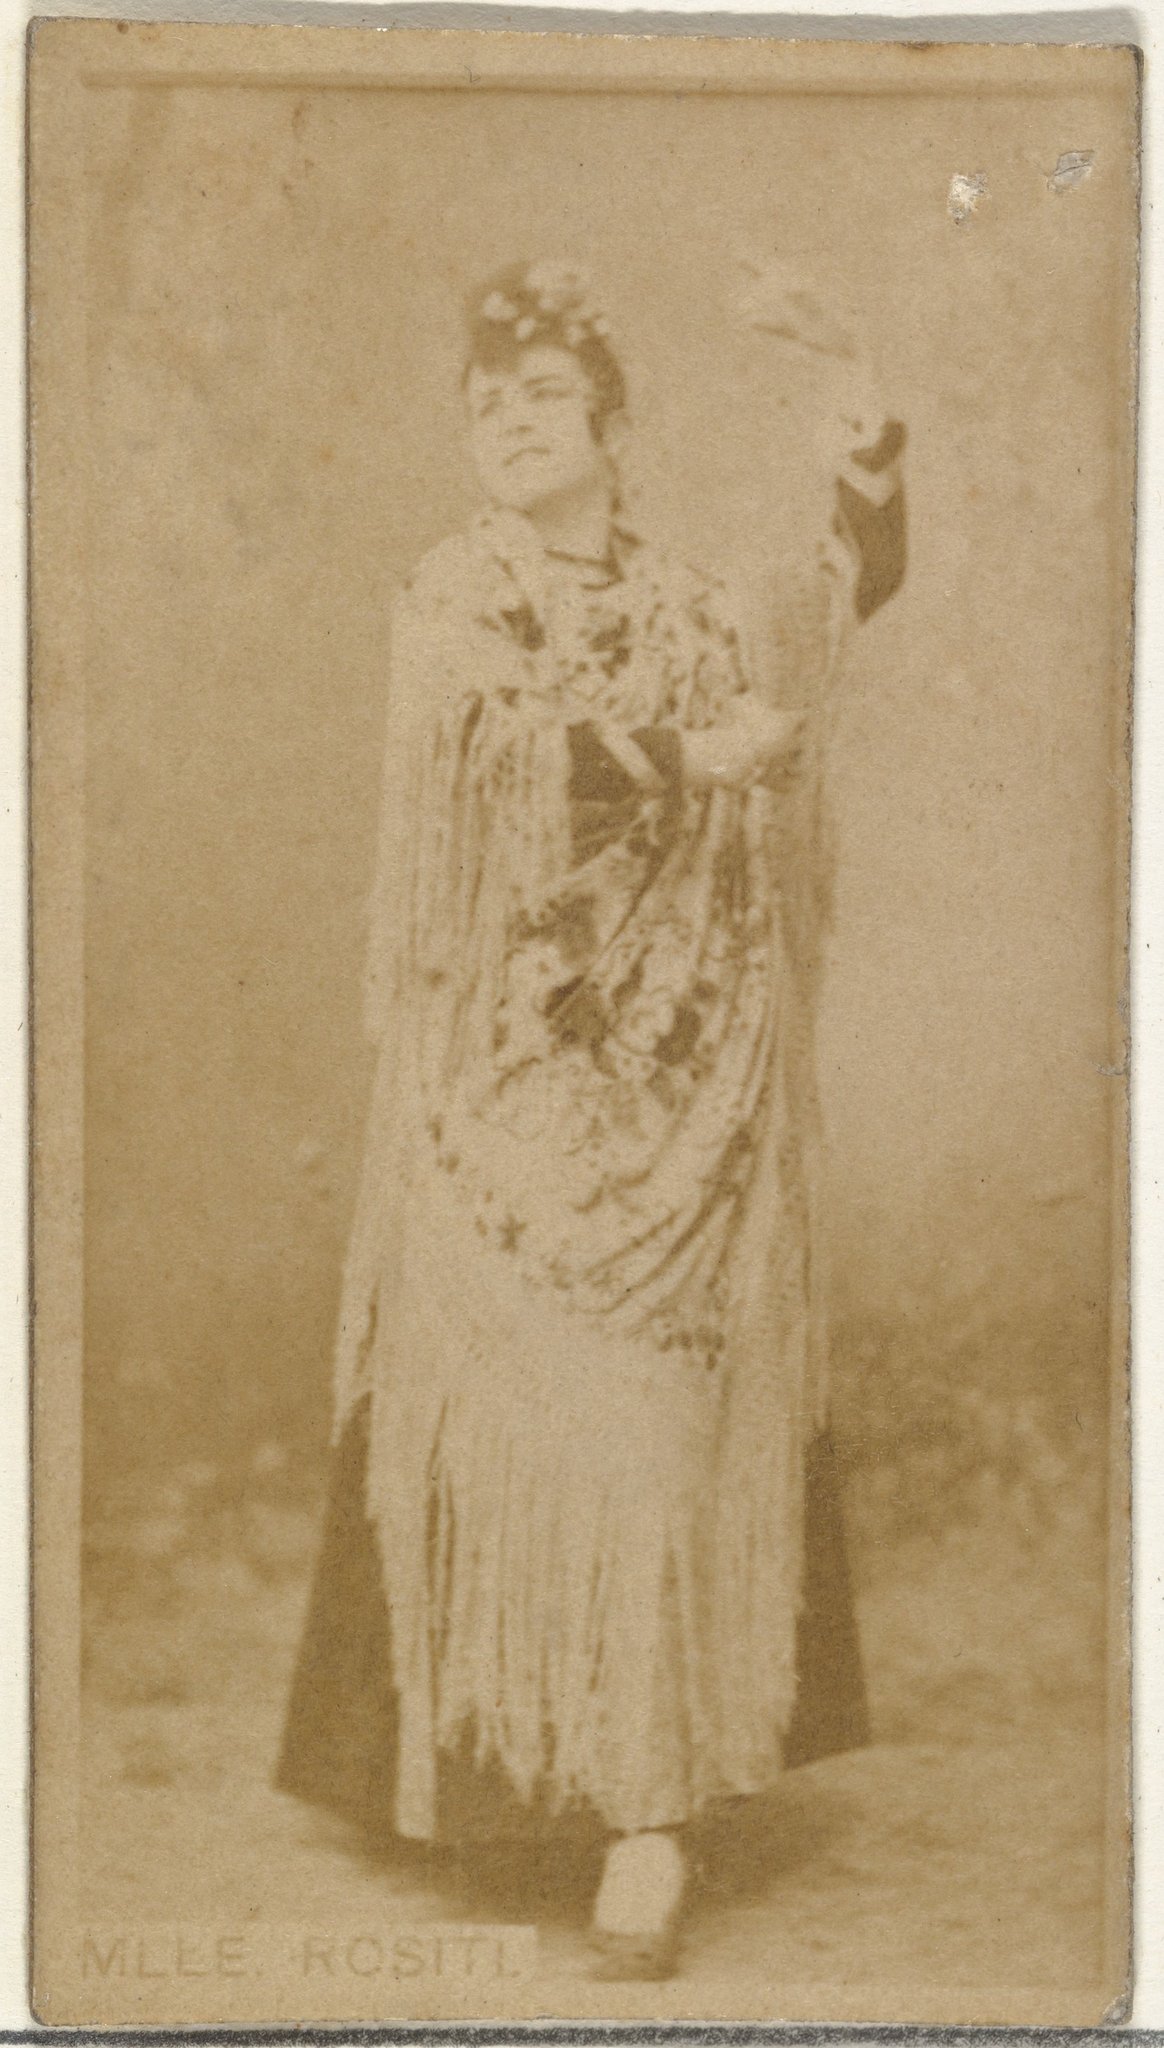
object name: photograph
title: Mlle. Rositi, from the Actors and Actresses series (N145-8) issued by Duke Sons & Co. to promote Duke Cigarettes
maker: w. duke, sons & co.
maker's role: publisher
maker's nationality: american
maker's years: 1870-1920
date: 1891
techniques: albumen silver print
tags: portraits,women,actresses